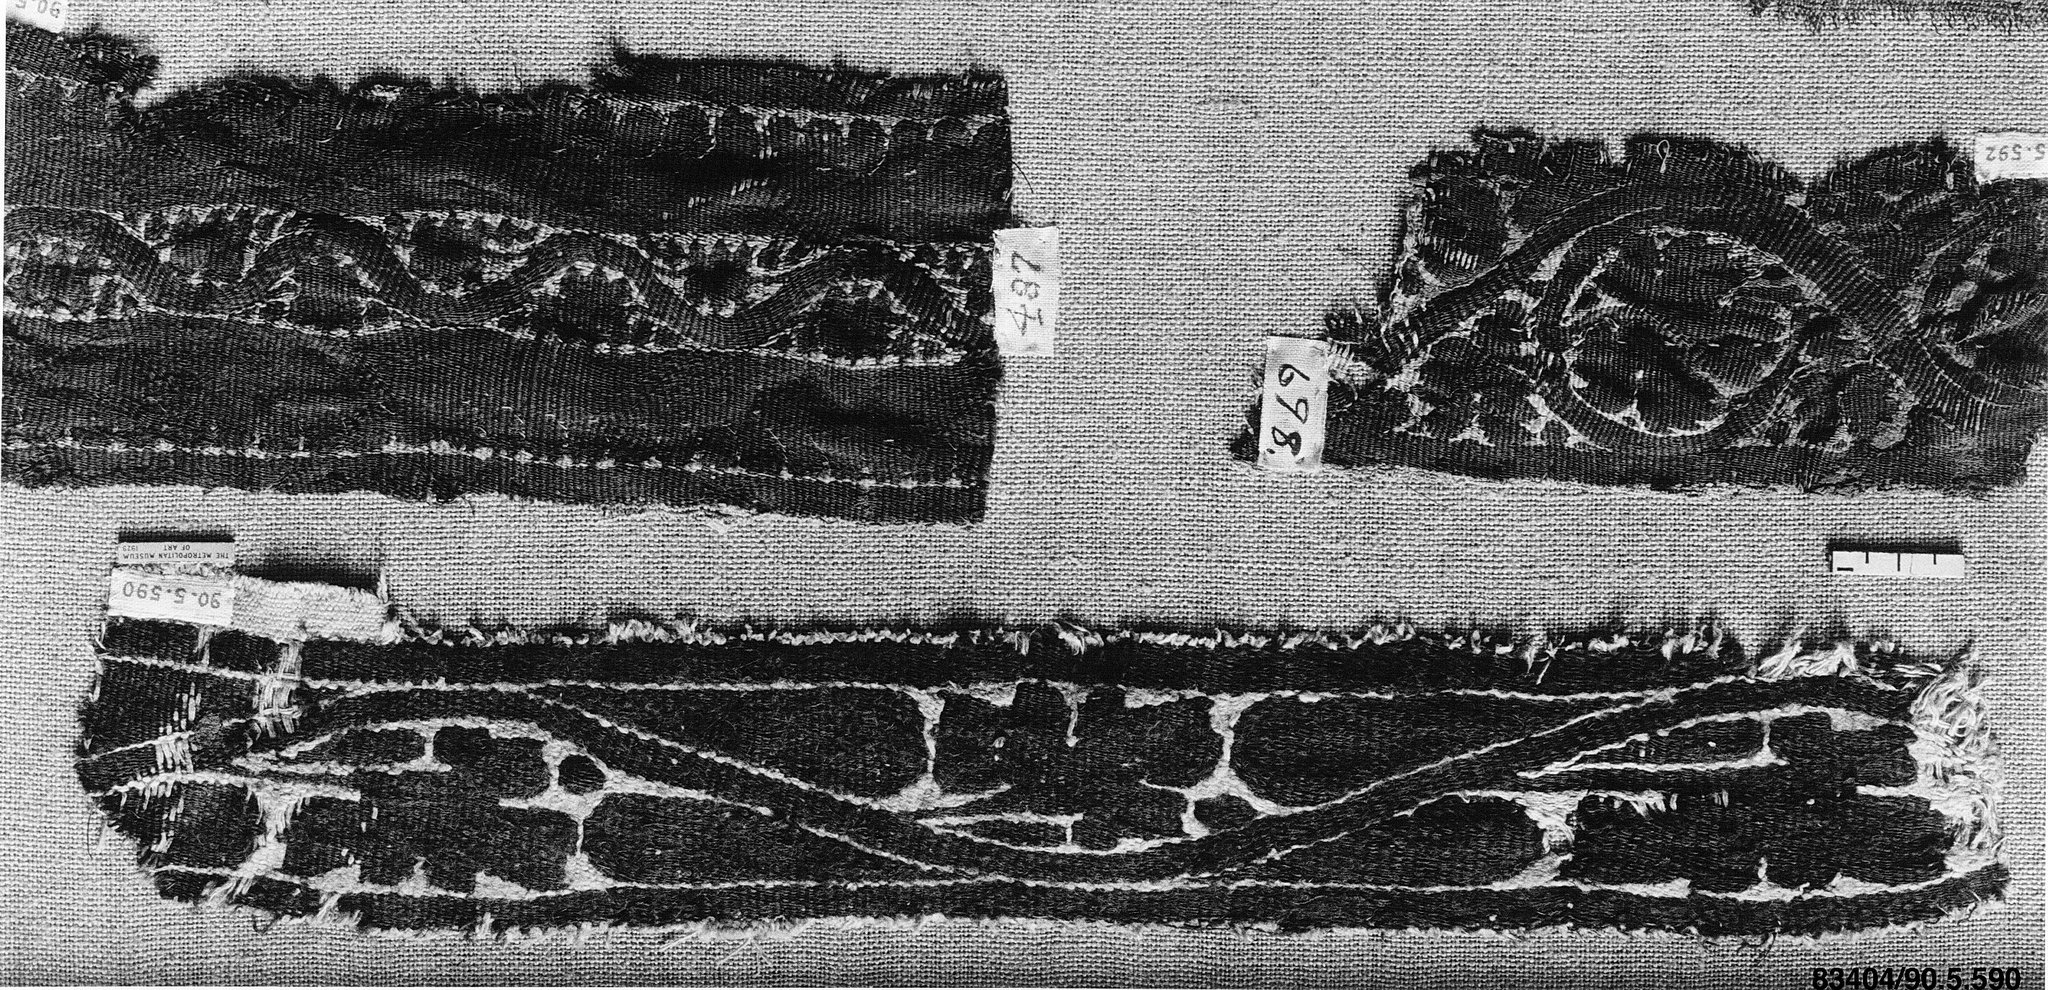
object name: textile fragment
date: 201-400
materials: linen, wool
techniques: weave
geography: egypt